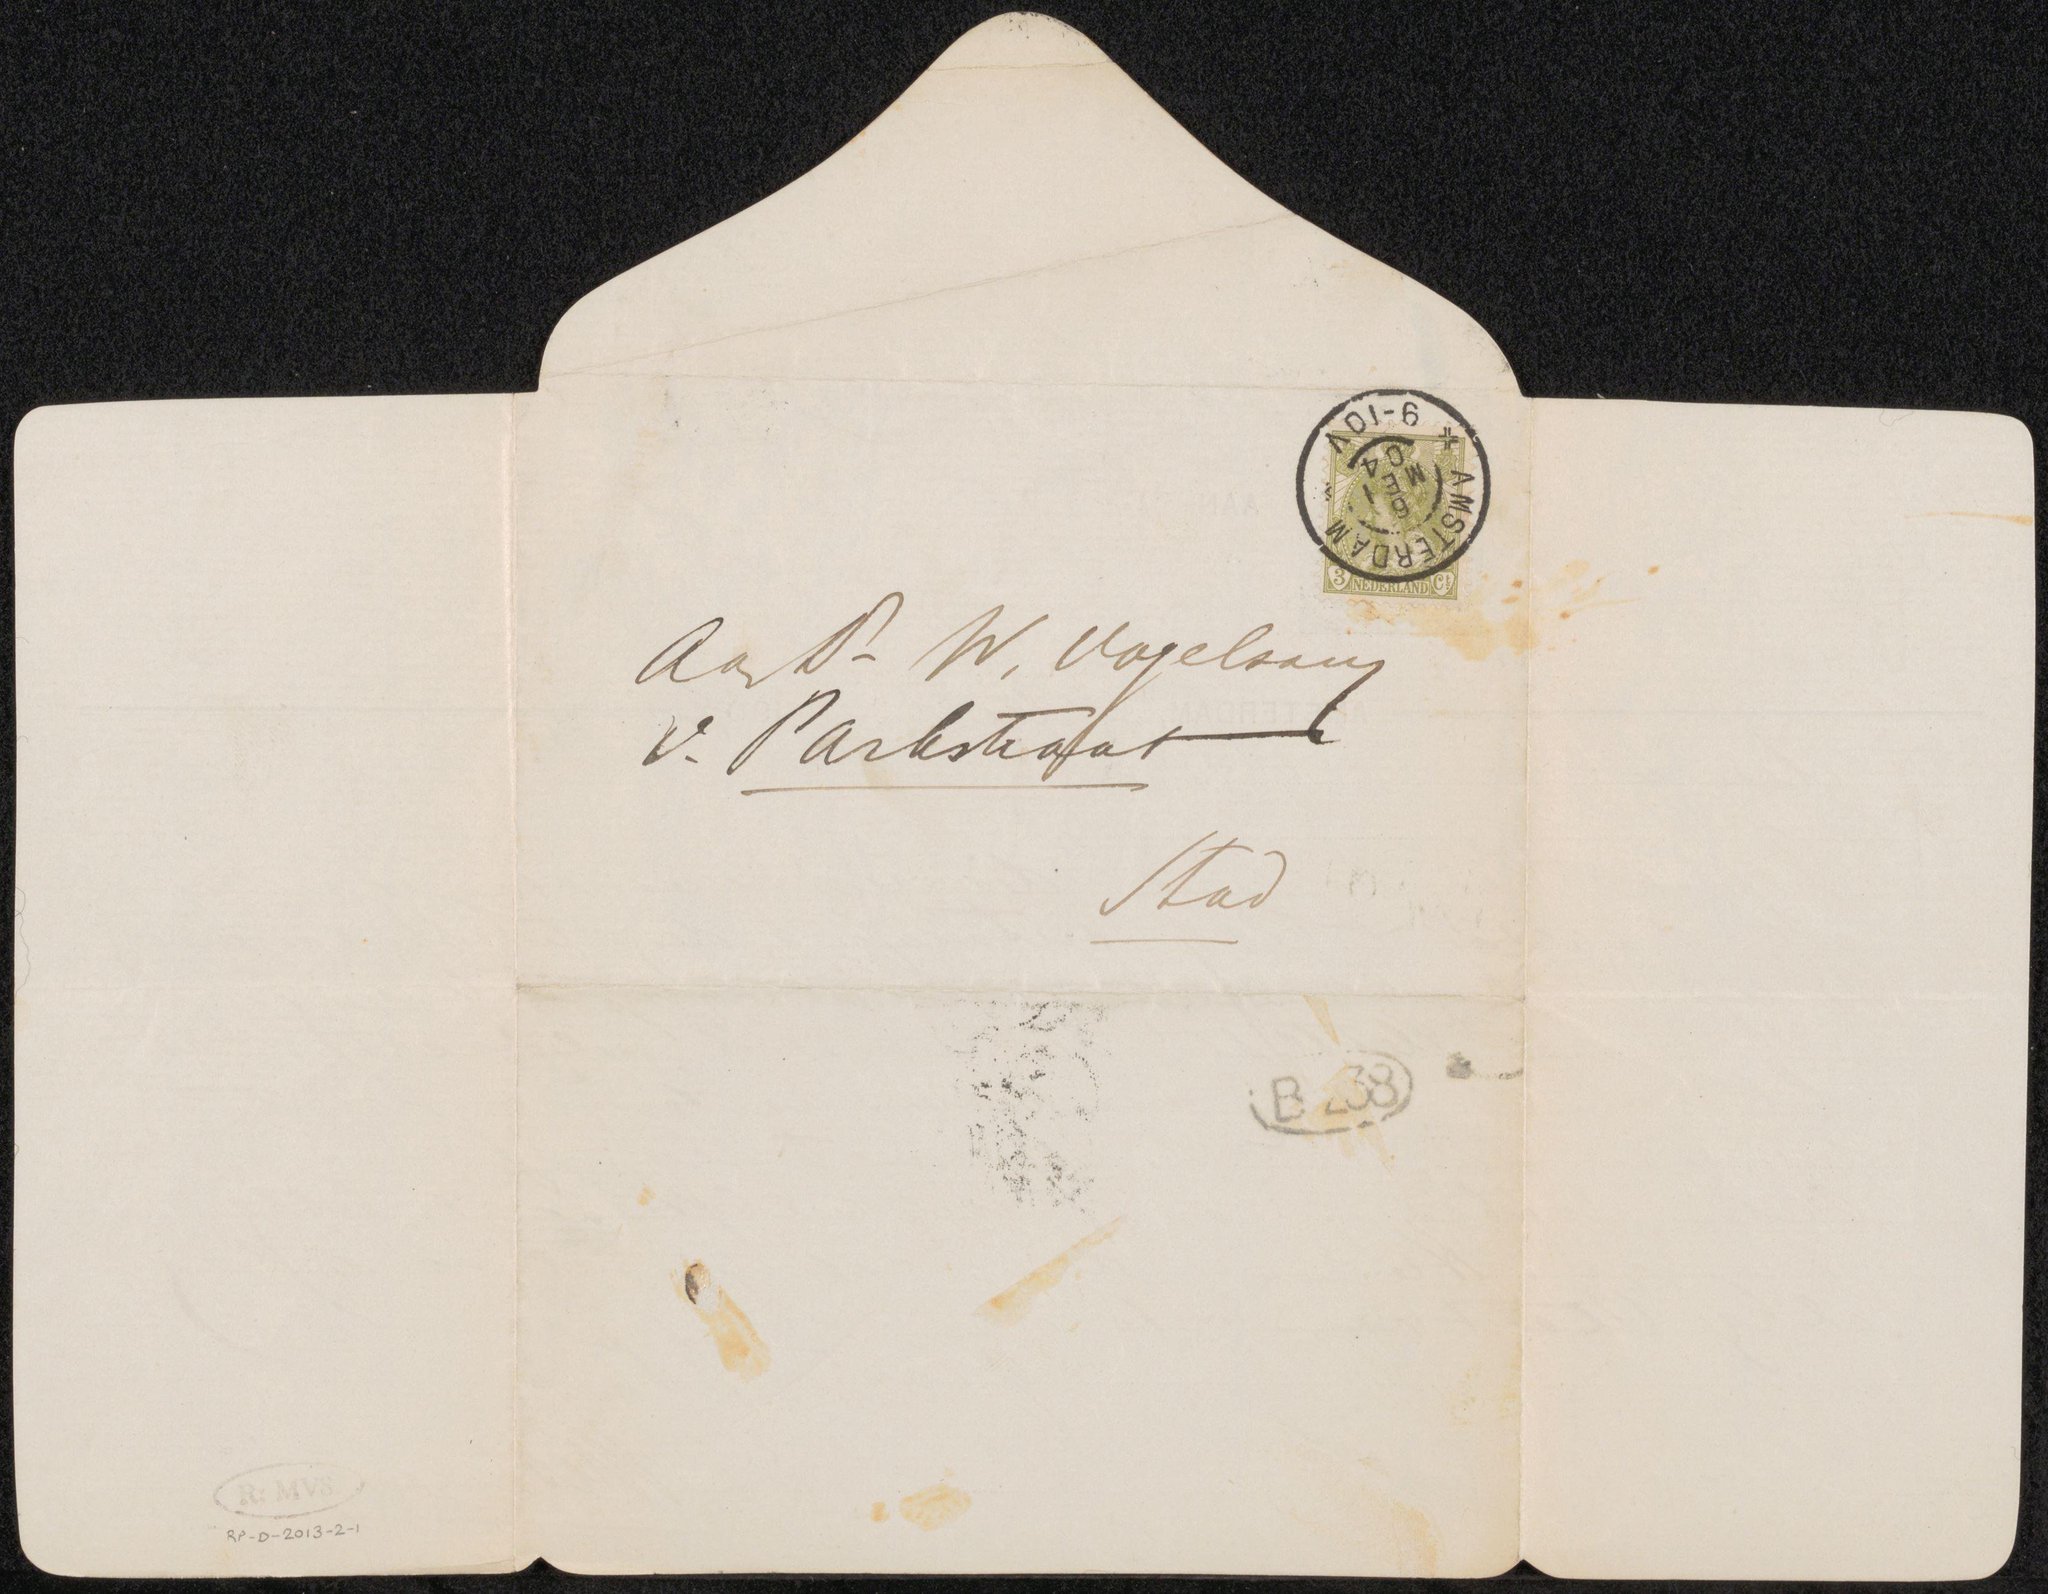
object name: letter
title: Brief aan Willem Vogelsang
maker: hendrik petrus berlage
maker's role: draughtsman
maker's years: 1856-1934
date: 1907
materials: ink, paper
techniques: pen, printing, writing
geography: amsterdam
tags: leiden, utrecht, willem vogelsang, amsterdam, print maker, draughtsman, designer, mathieu lauweriks, money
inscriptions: collector's mark: Lugt 2228